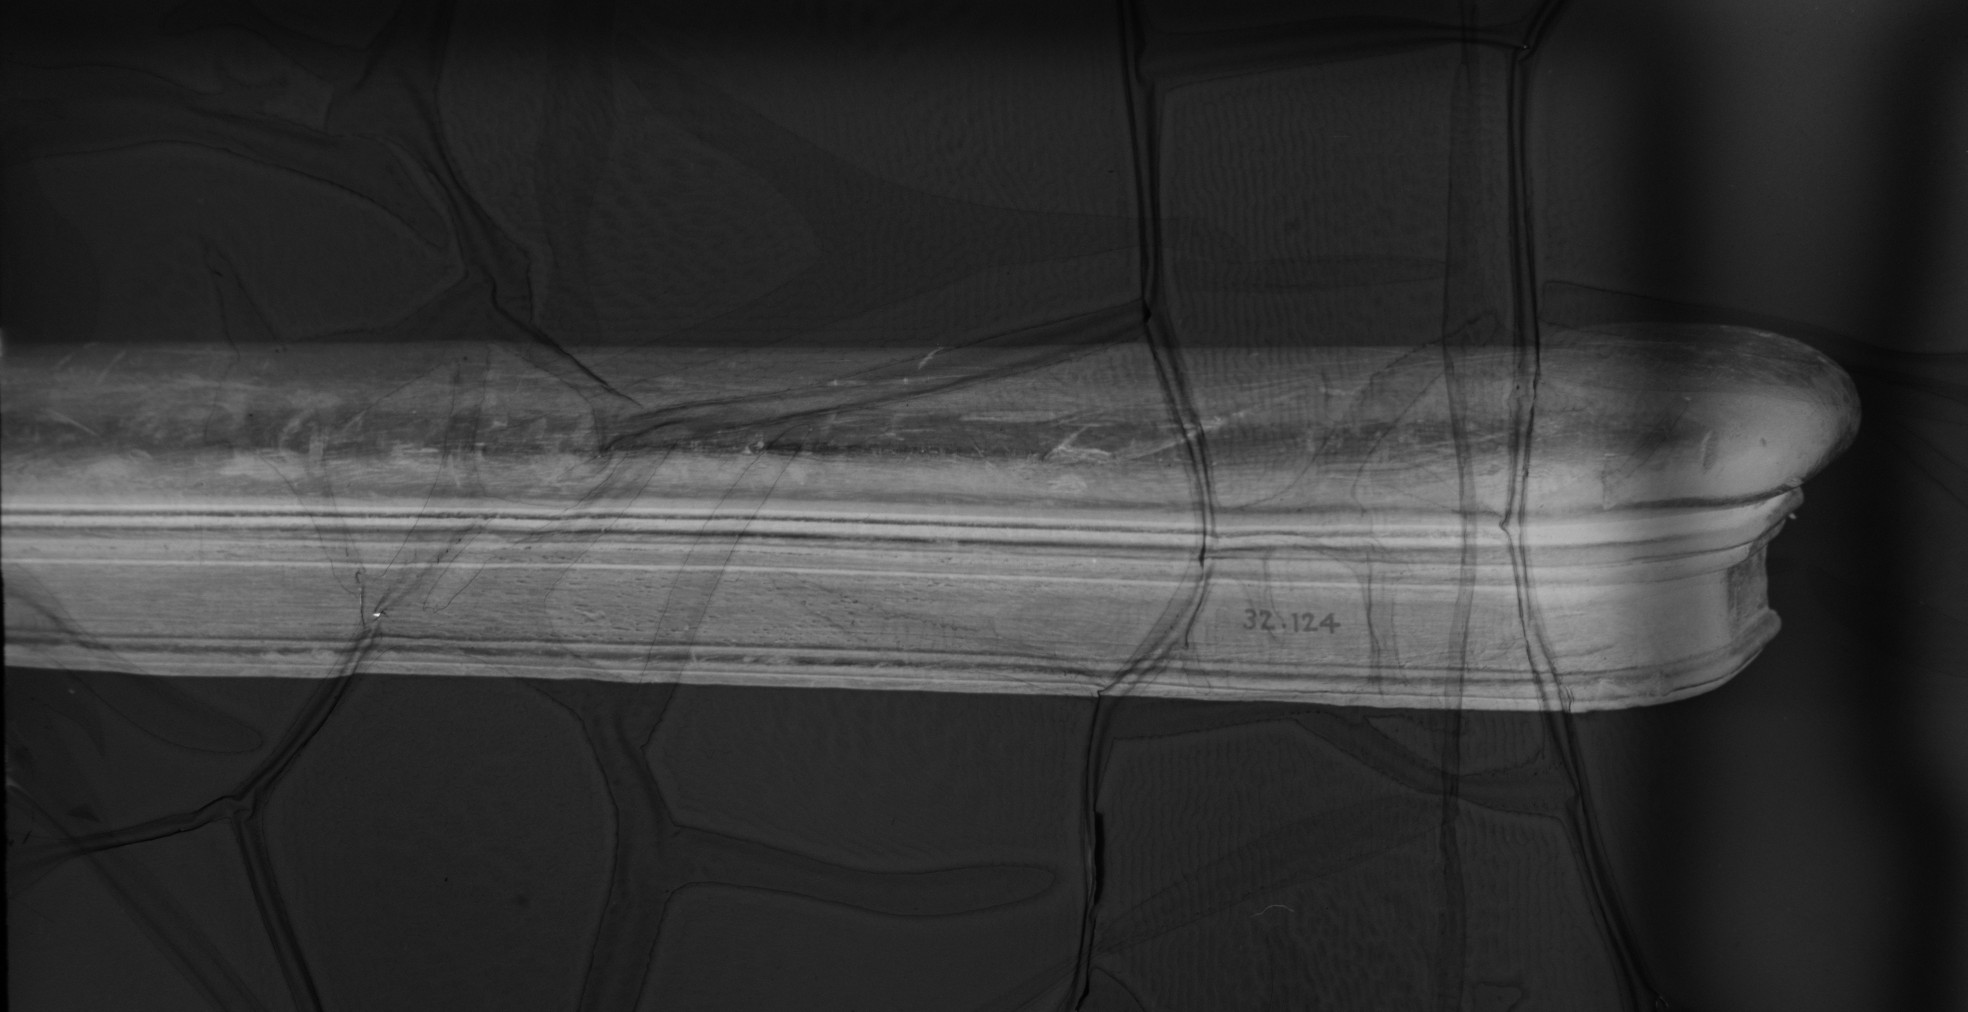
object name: hand rail fragment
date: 1701-1800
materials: wood